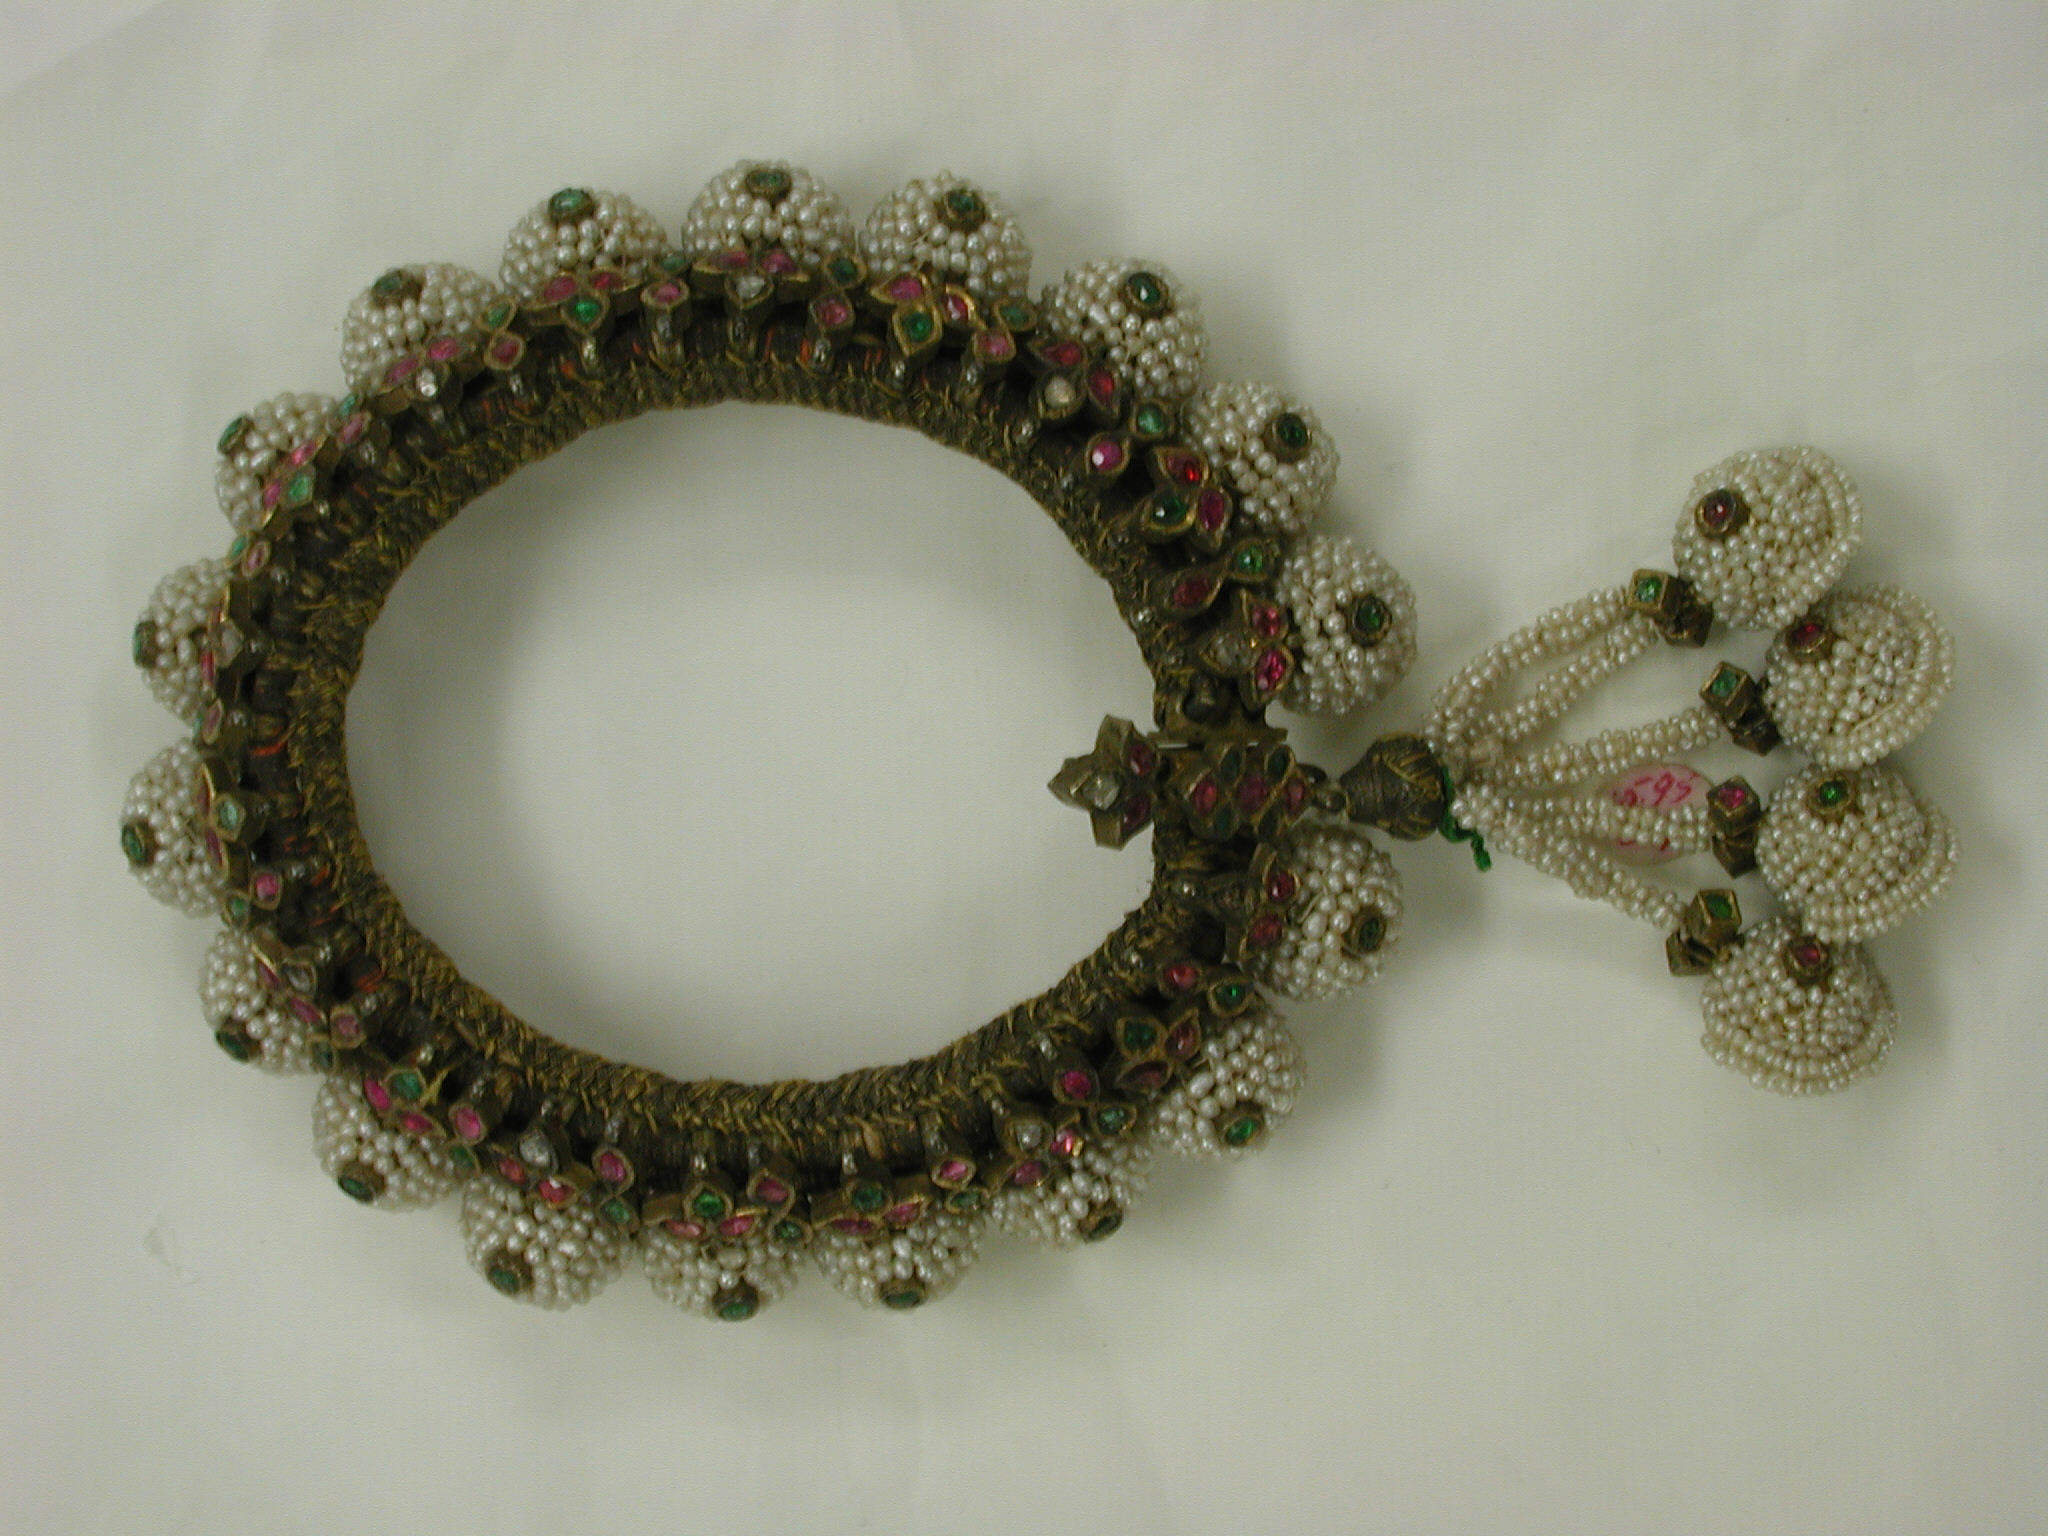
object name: anklet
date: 1701-1800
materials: diamond, gemstone, gold, pearl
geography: india